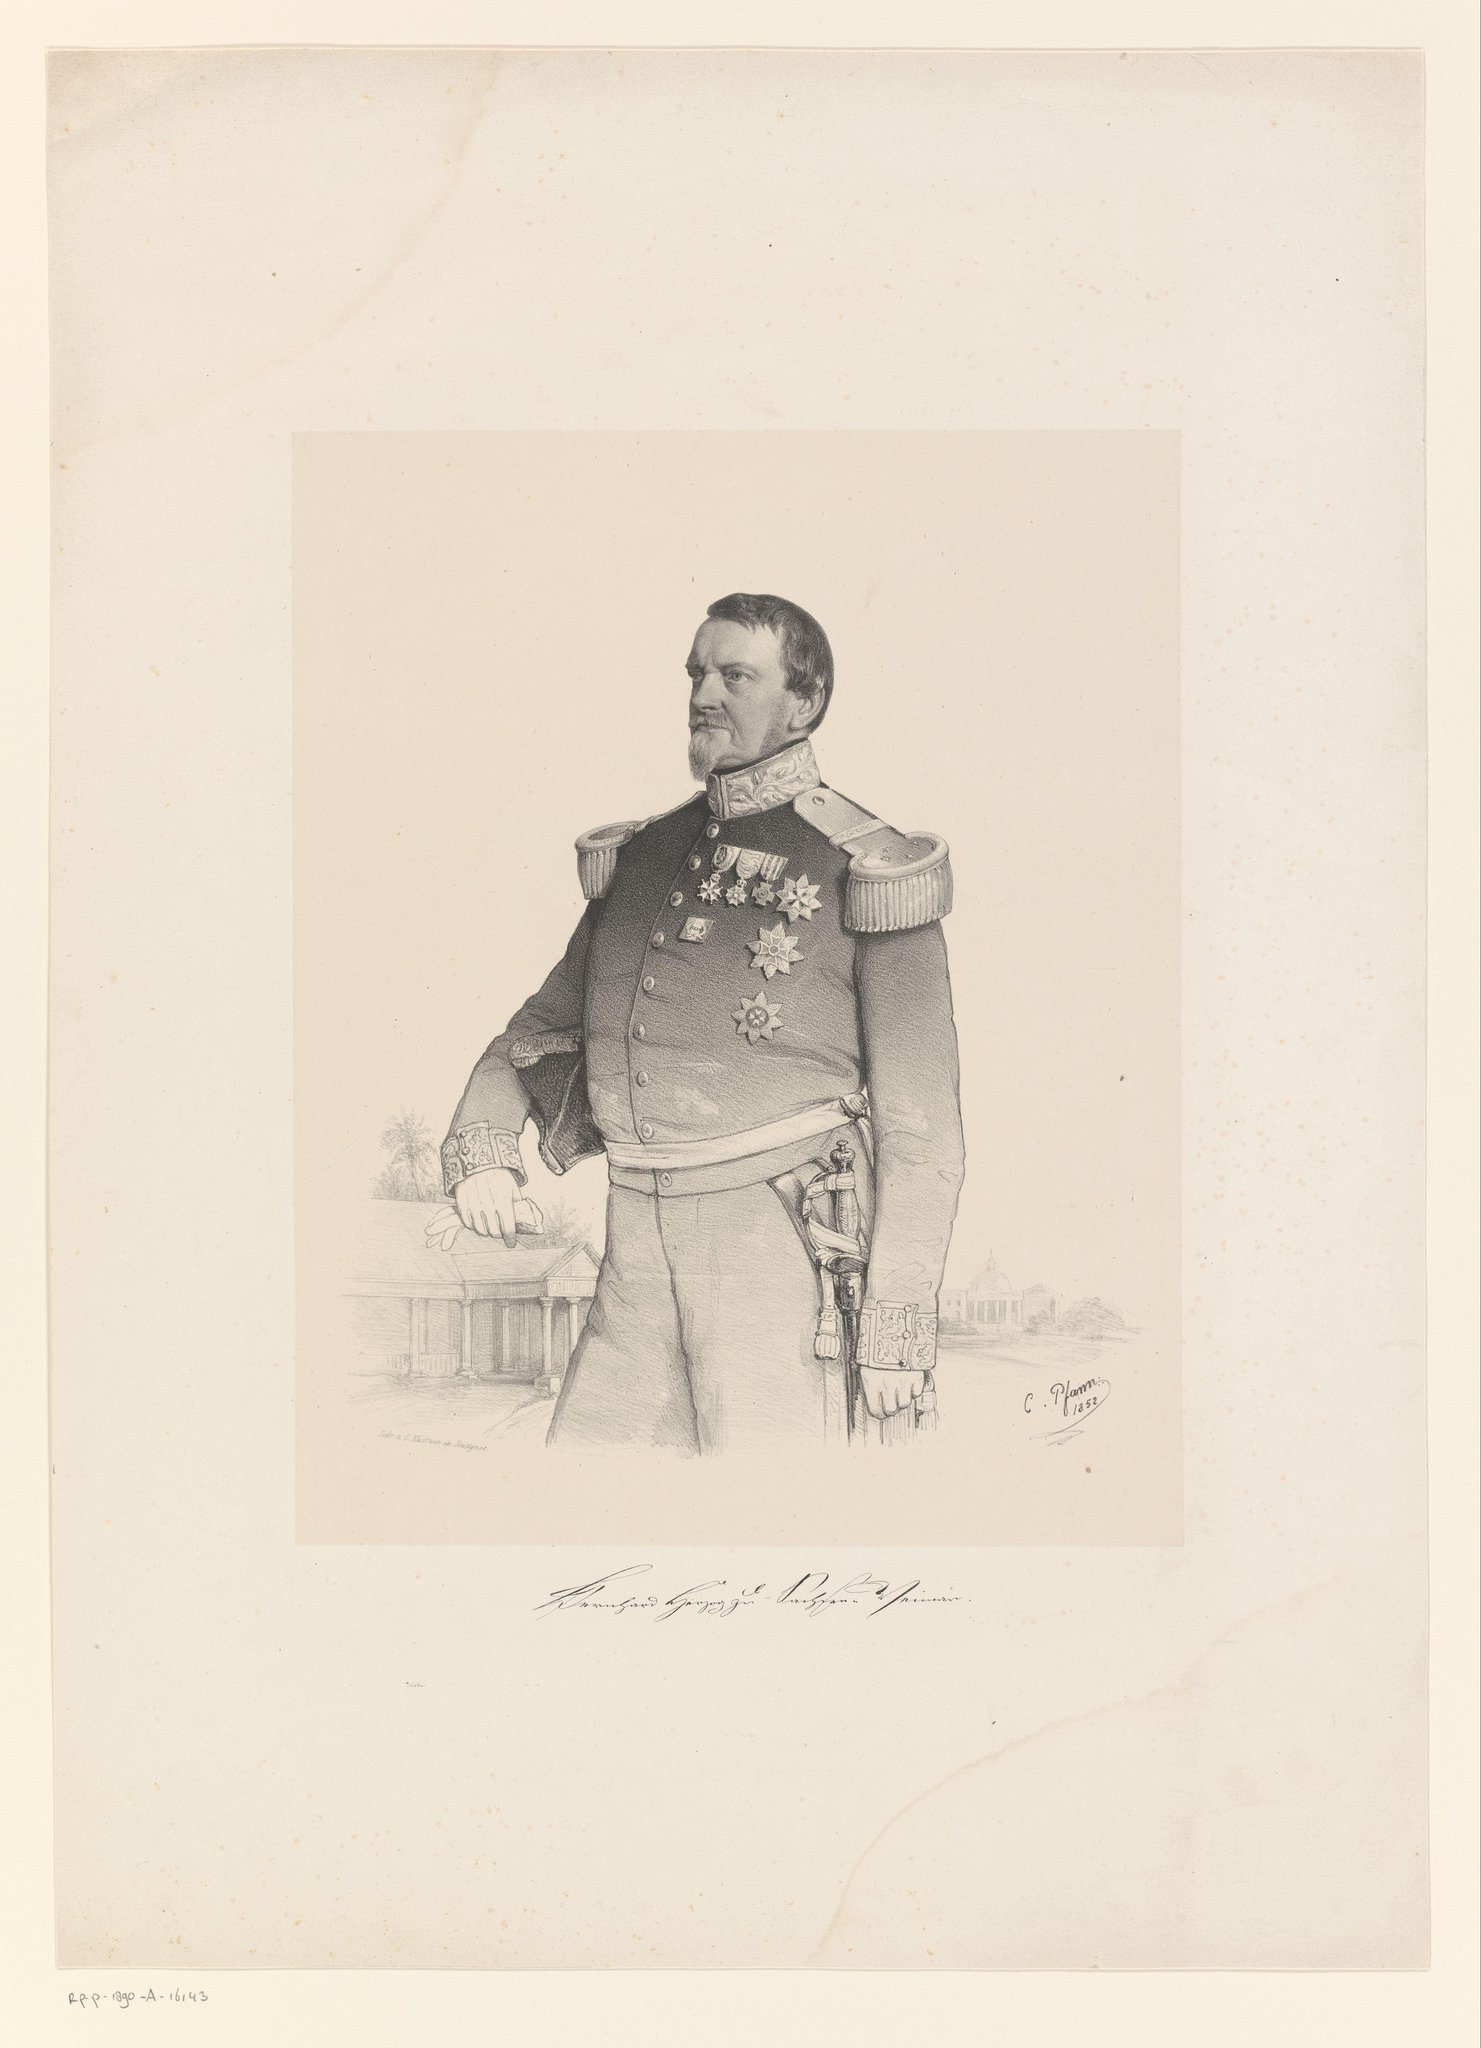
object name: print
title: Portret van Karel Bernhard, hertog van Saksen-Weimar-Eisenach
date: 1852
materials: paper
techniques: lithograph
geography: stuttgart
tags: karel bernhard (hertog van saksen-weimar-eisenach), commander-in-chief, general, marshal, adult man, historical persons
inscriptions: collector's mark: Lugt 2228